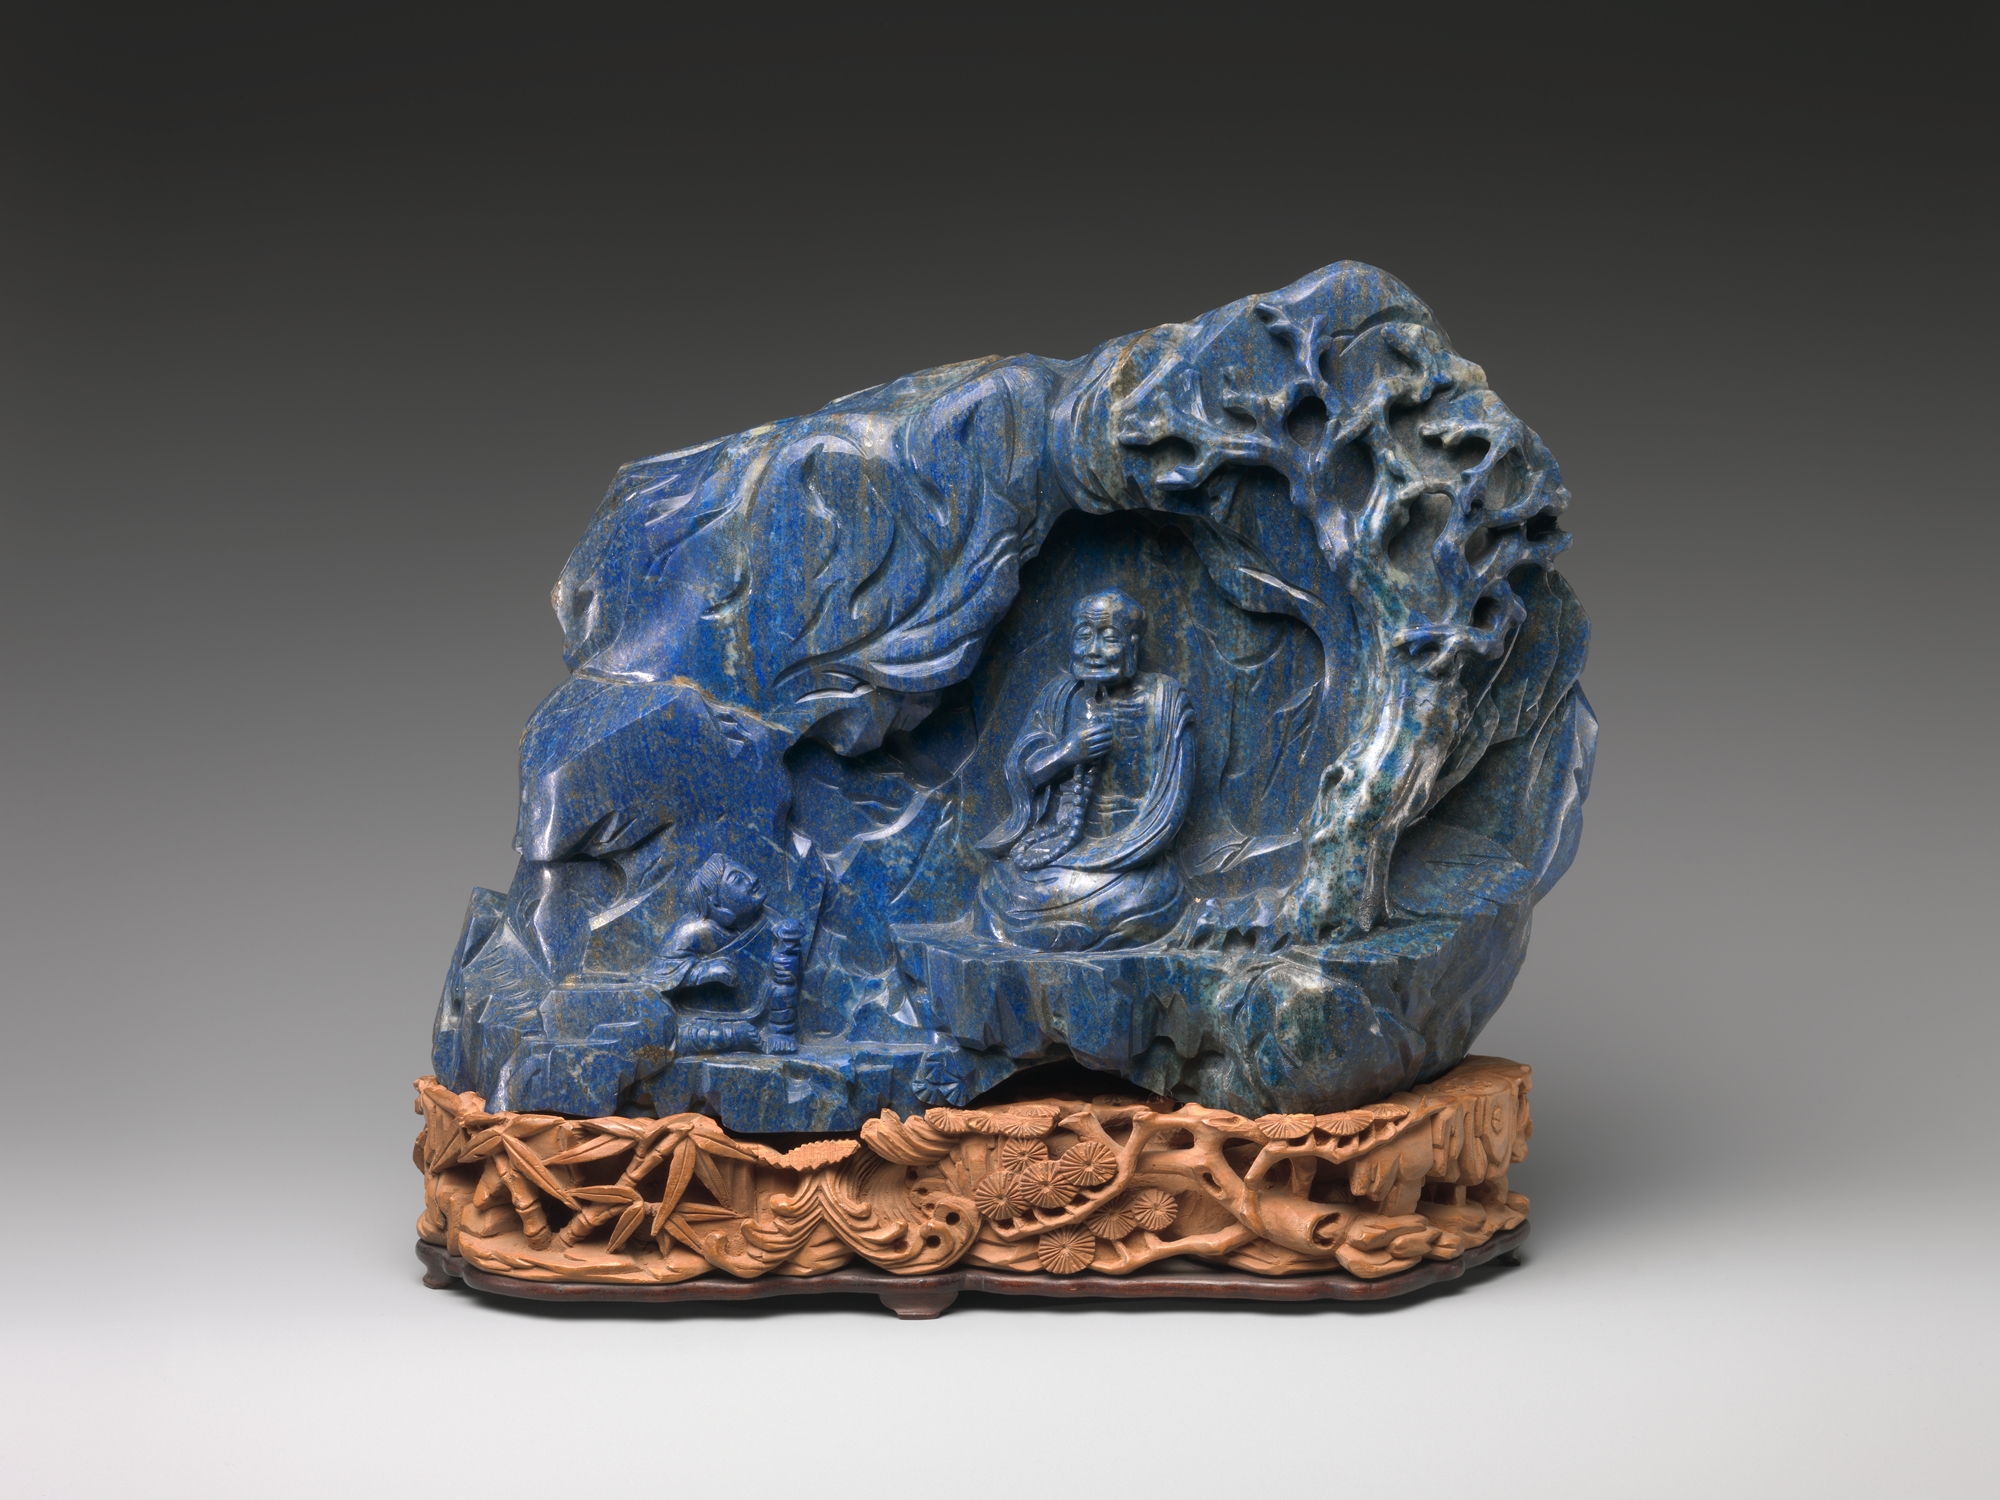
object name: sculpture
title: Seated luohan (arhat) in a grotto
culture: chinese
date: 1701-1900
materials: lapis lazuli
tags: men,landscapes